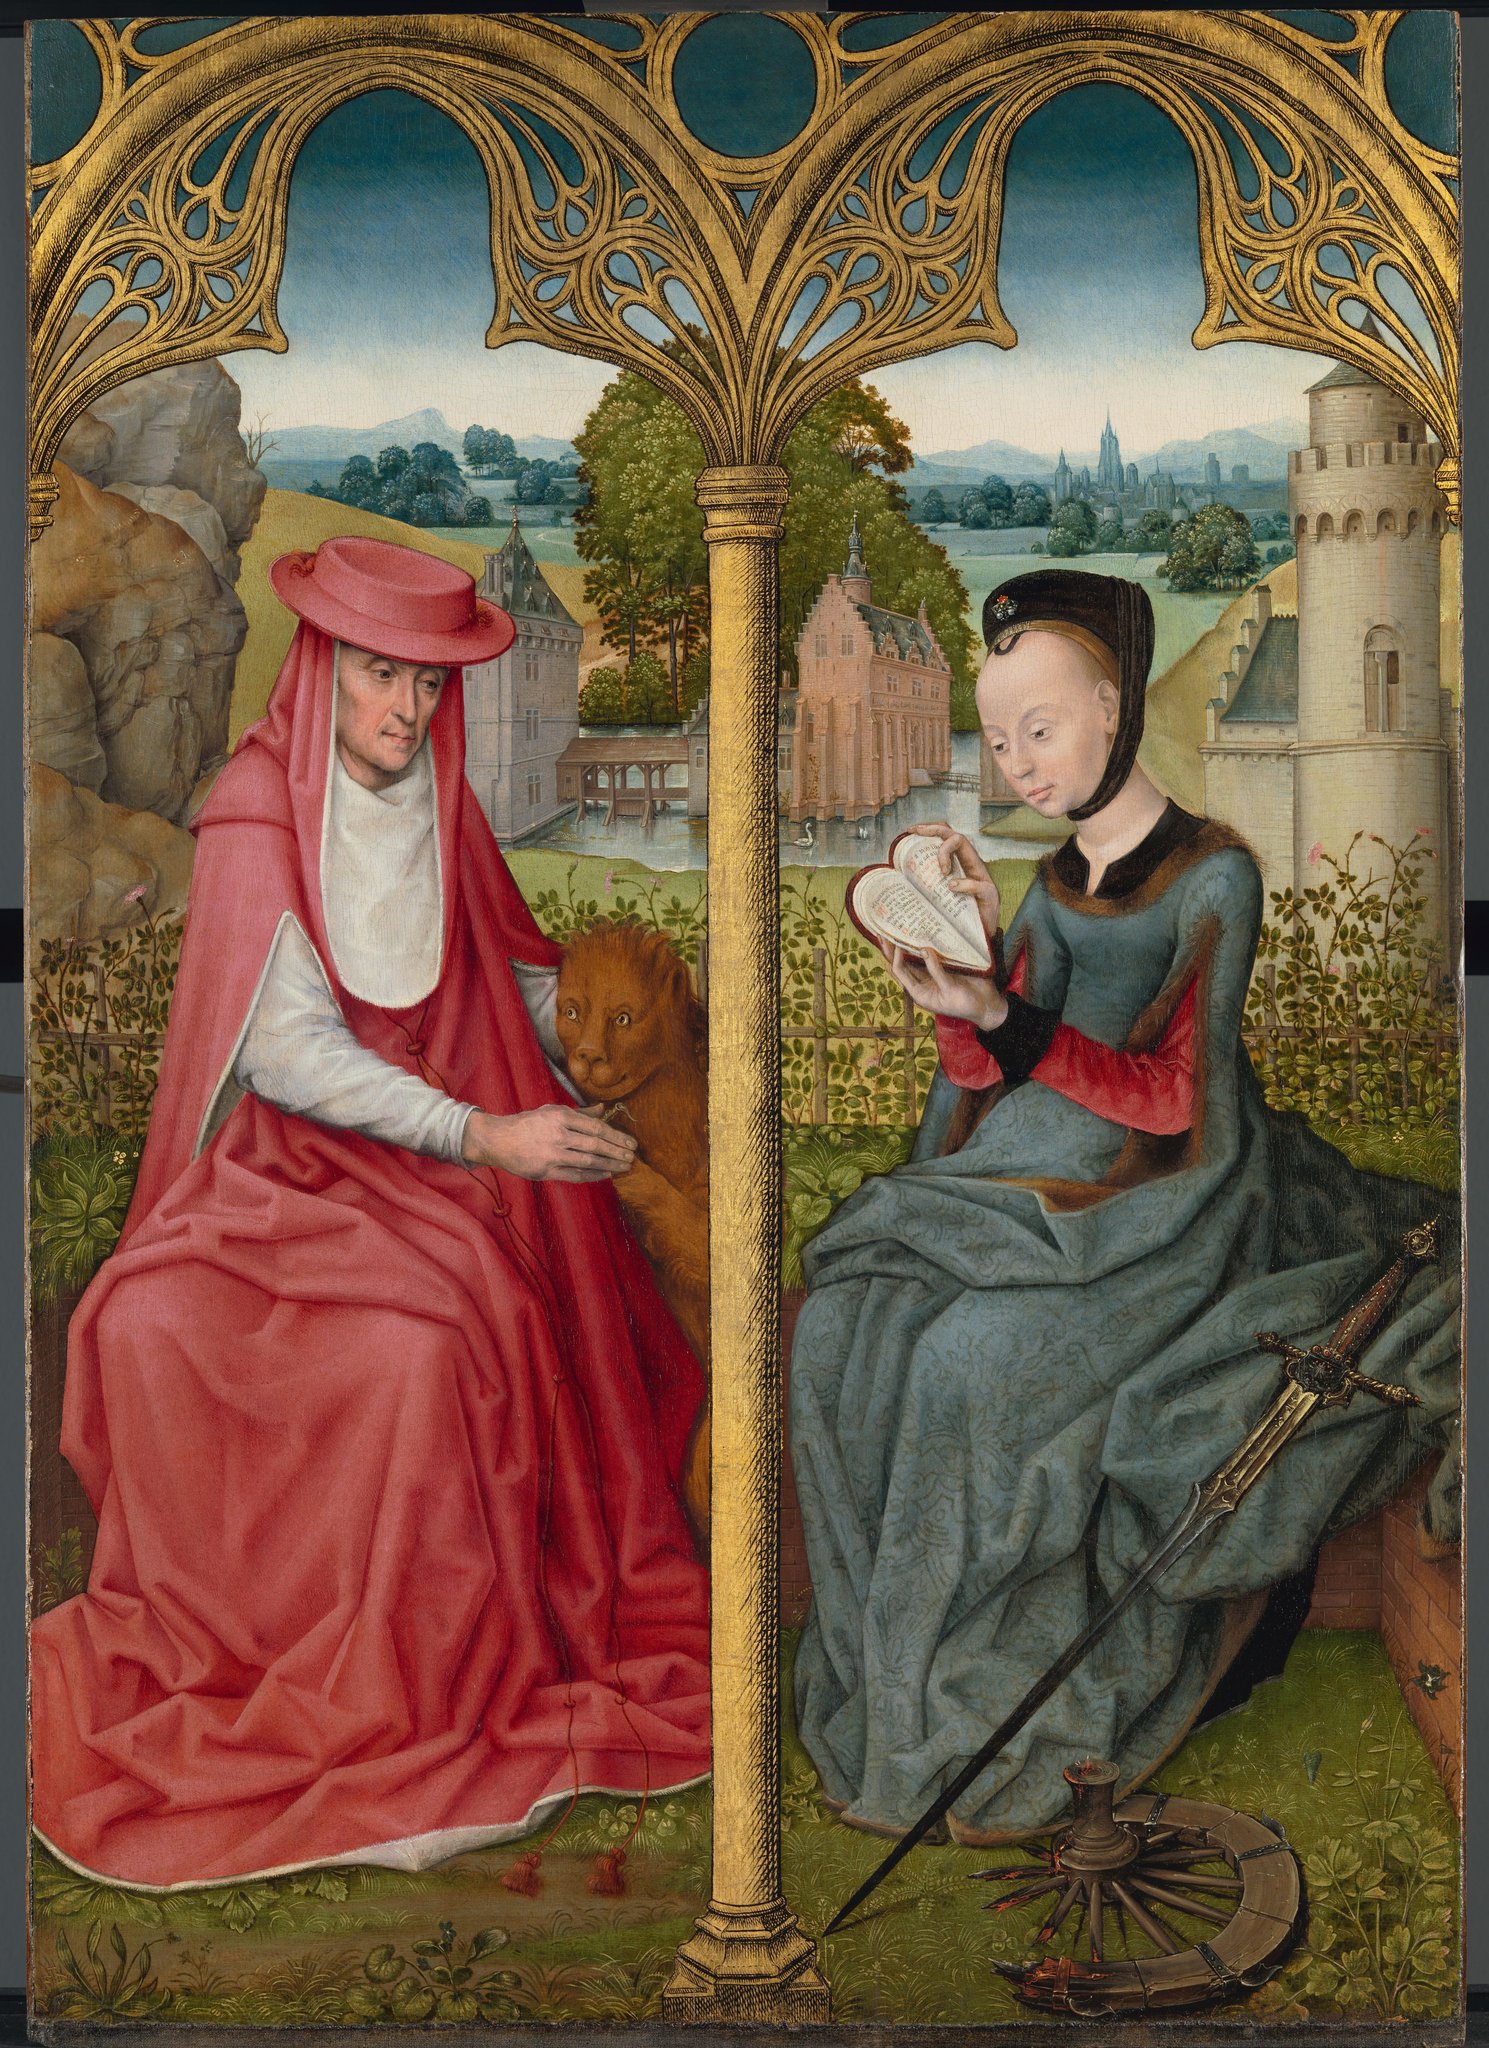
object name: painting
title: St Jerome and St Catherine of Alexandria, Bruges or Brussels, c. 1480-1490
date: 1480-1490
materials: wood, oil, panel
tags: the virgin martyr catherine of alexandria; possible attributes: book, crown, emperor maxentius, palm-branch, ring, sword, wheel, the monk and hermit jerome (hieronymus); possible attributes: book, cardinal's hat, crucifix, hour-glass, lion, skull, stone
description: Jerome and Catherine sit on a grass-covered bench before some rose bushes. The two saints can be identified by their attributes: Jerome with the lion, and Catherine with the sword and the broken wheel. Catherine was the daughter of a king and served as a role model for wealthy courtly ladies. The costly heartshaped book she holds probably contains profane love songs. Are we looking at a portrait?